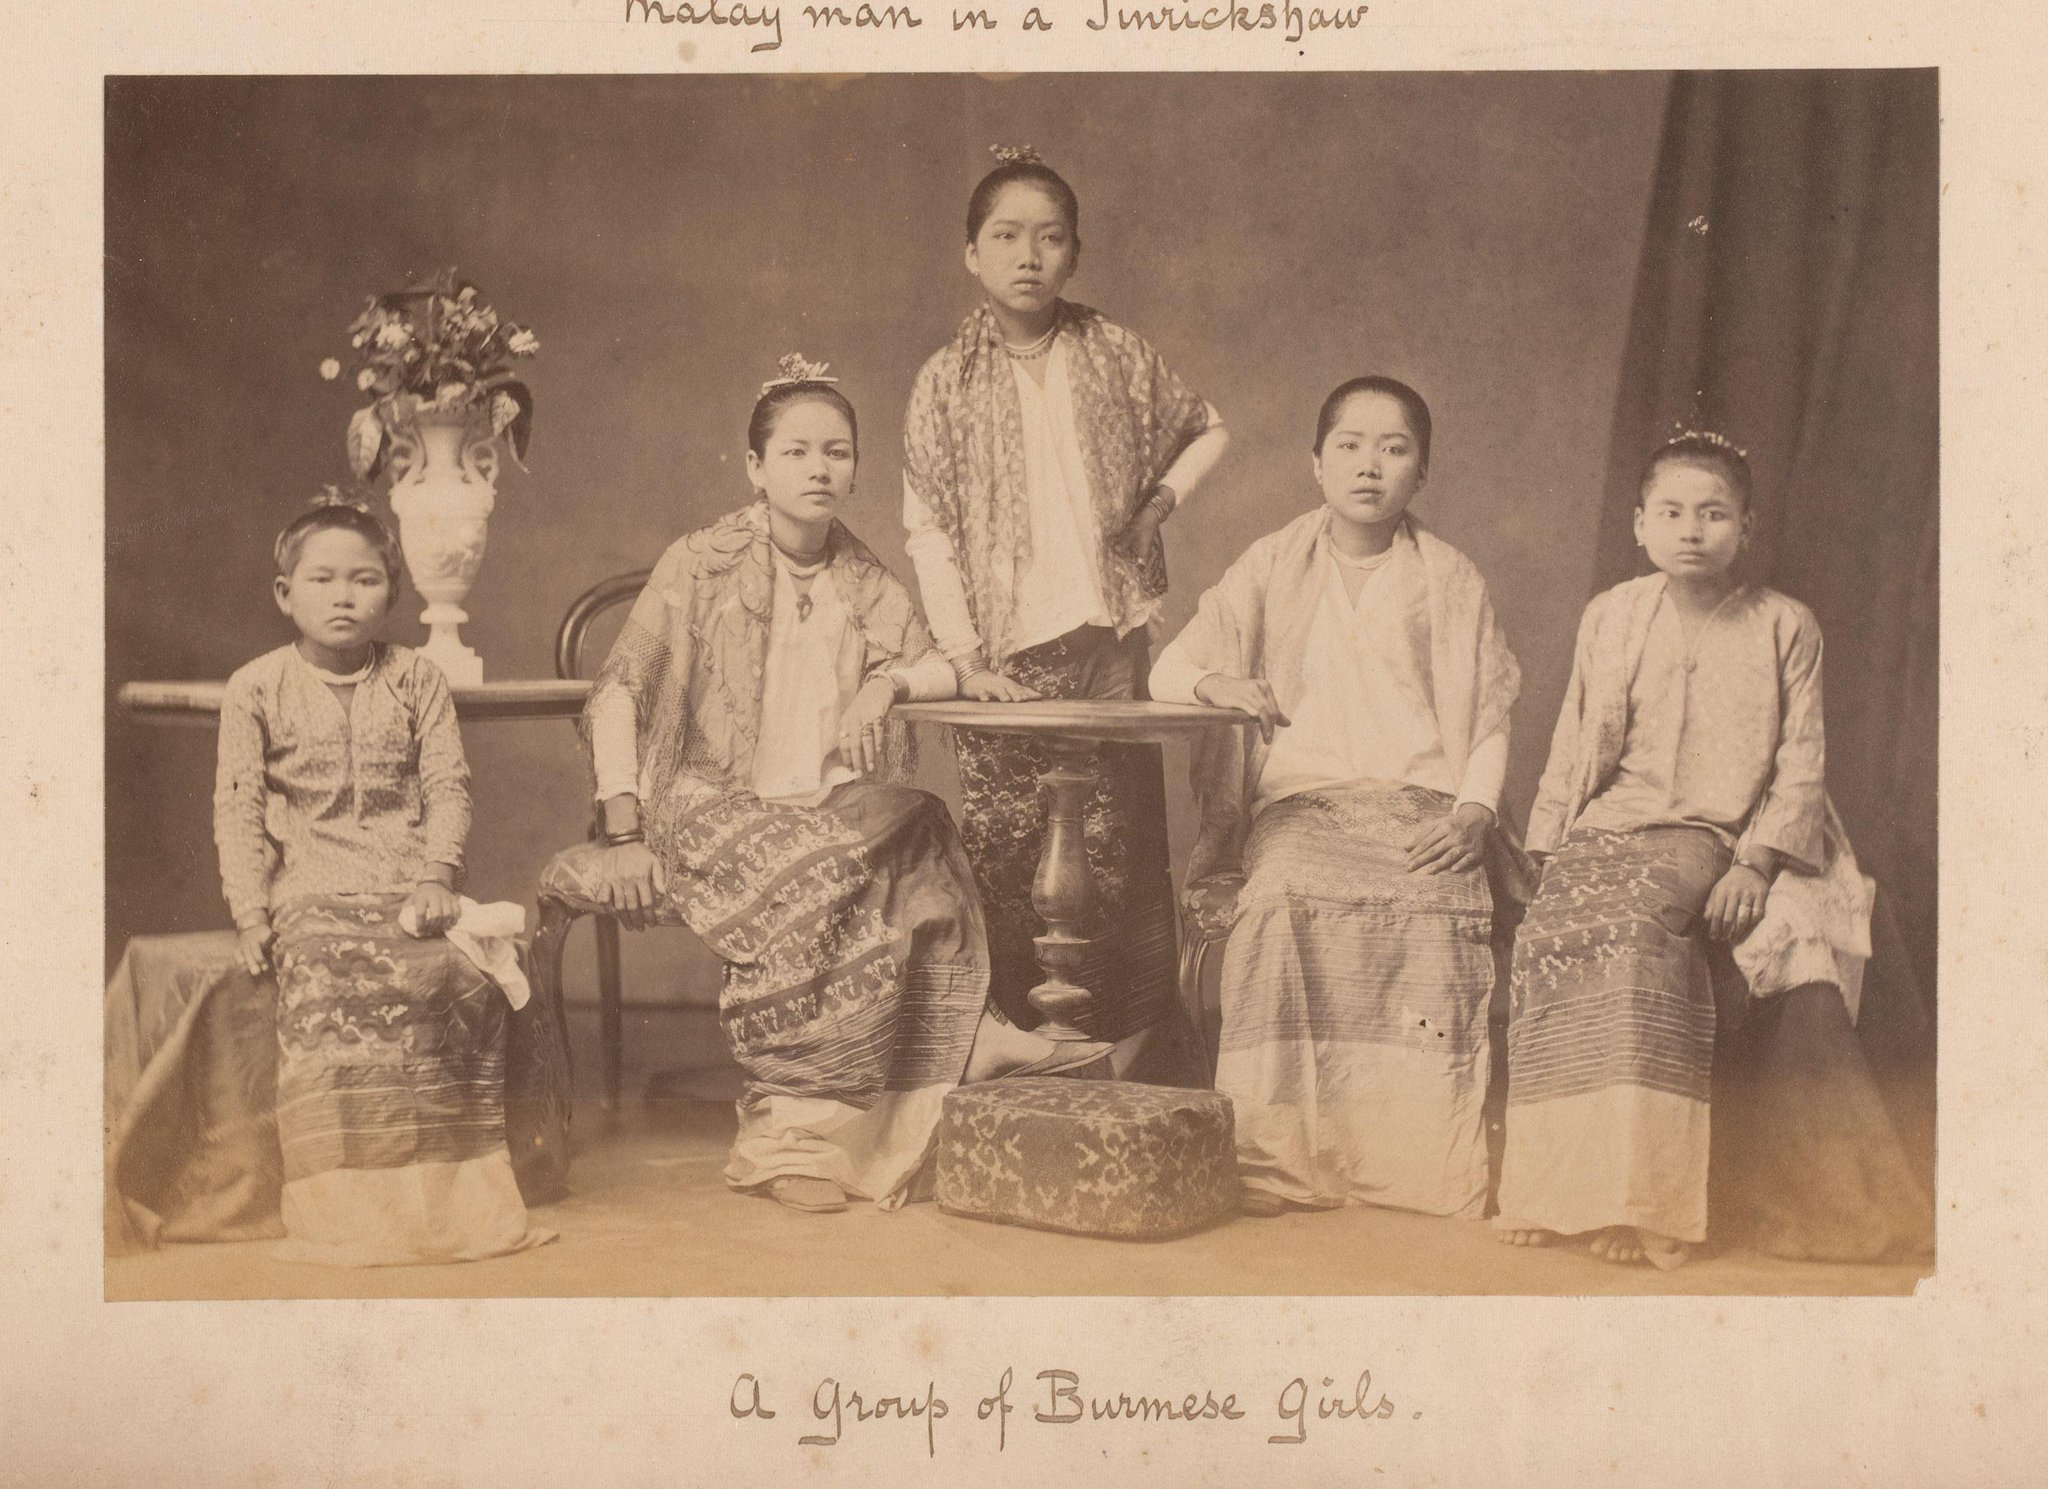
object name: album leaf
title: A group of Burmese girls, Myanmar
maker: Anonymous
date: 1880-1900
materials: cardboard, photographic support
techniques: albumen print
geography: myanmar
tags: myanmar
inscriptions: caption: ‘a group of Burmese girls’